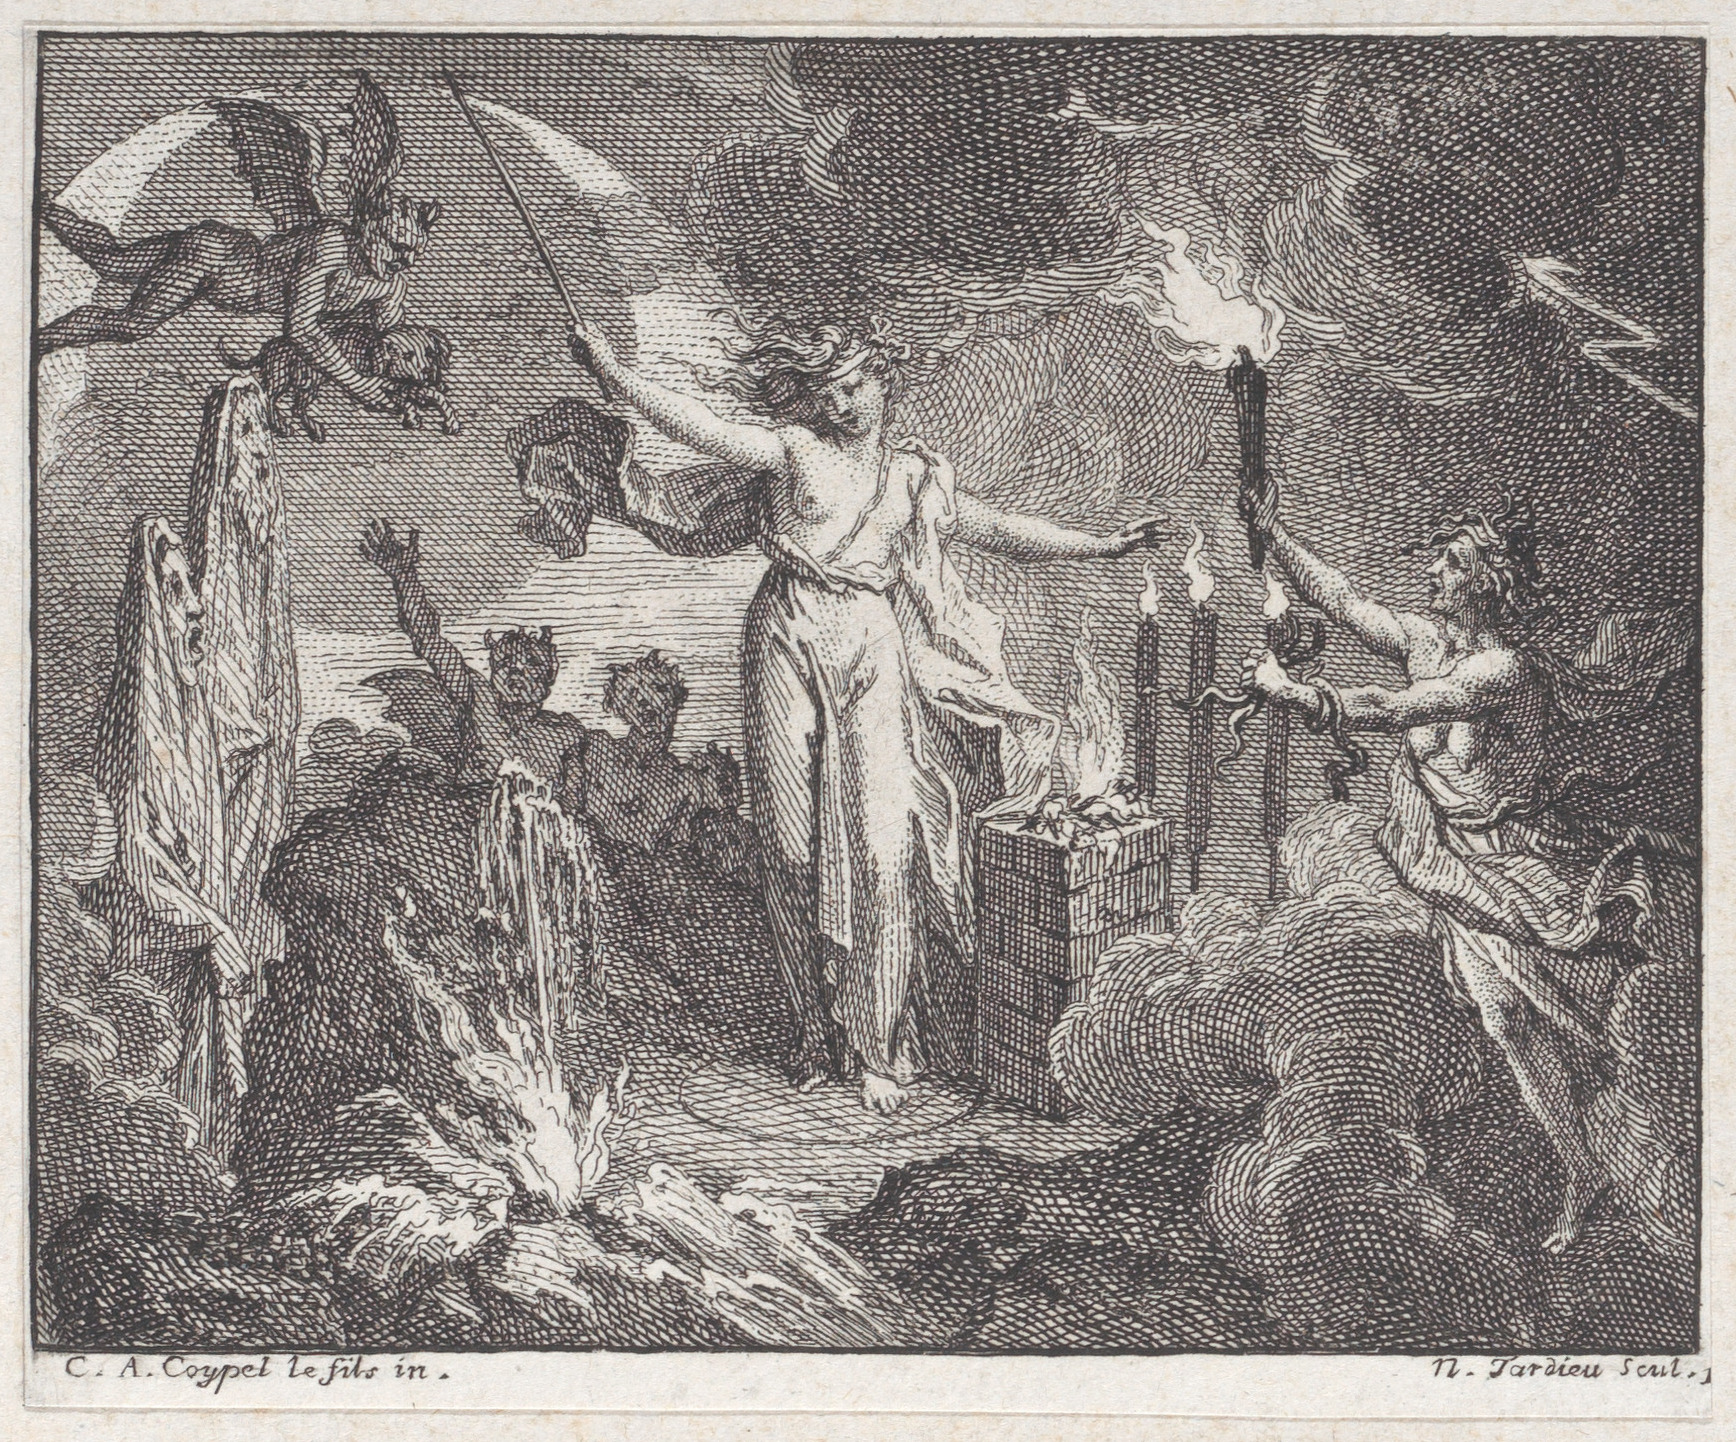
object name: print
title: Book 1, Fable 16: The Magician (La Magicienne), from "Fables Nouvelles"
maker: nicolas henry tardieu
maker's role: artist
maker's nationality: french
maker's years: 1674-1749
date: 1719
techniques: engraving, etching